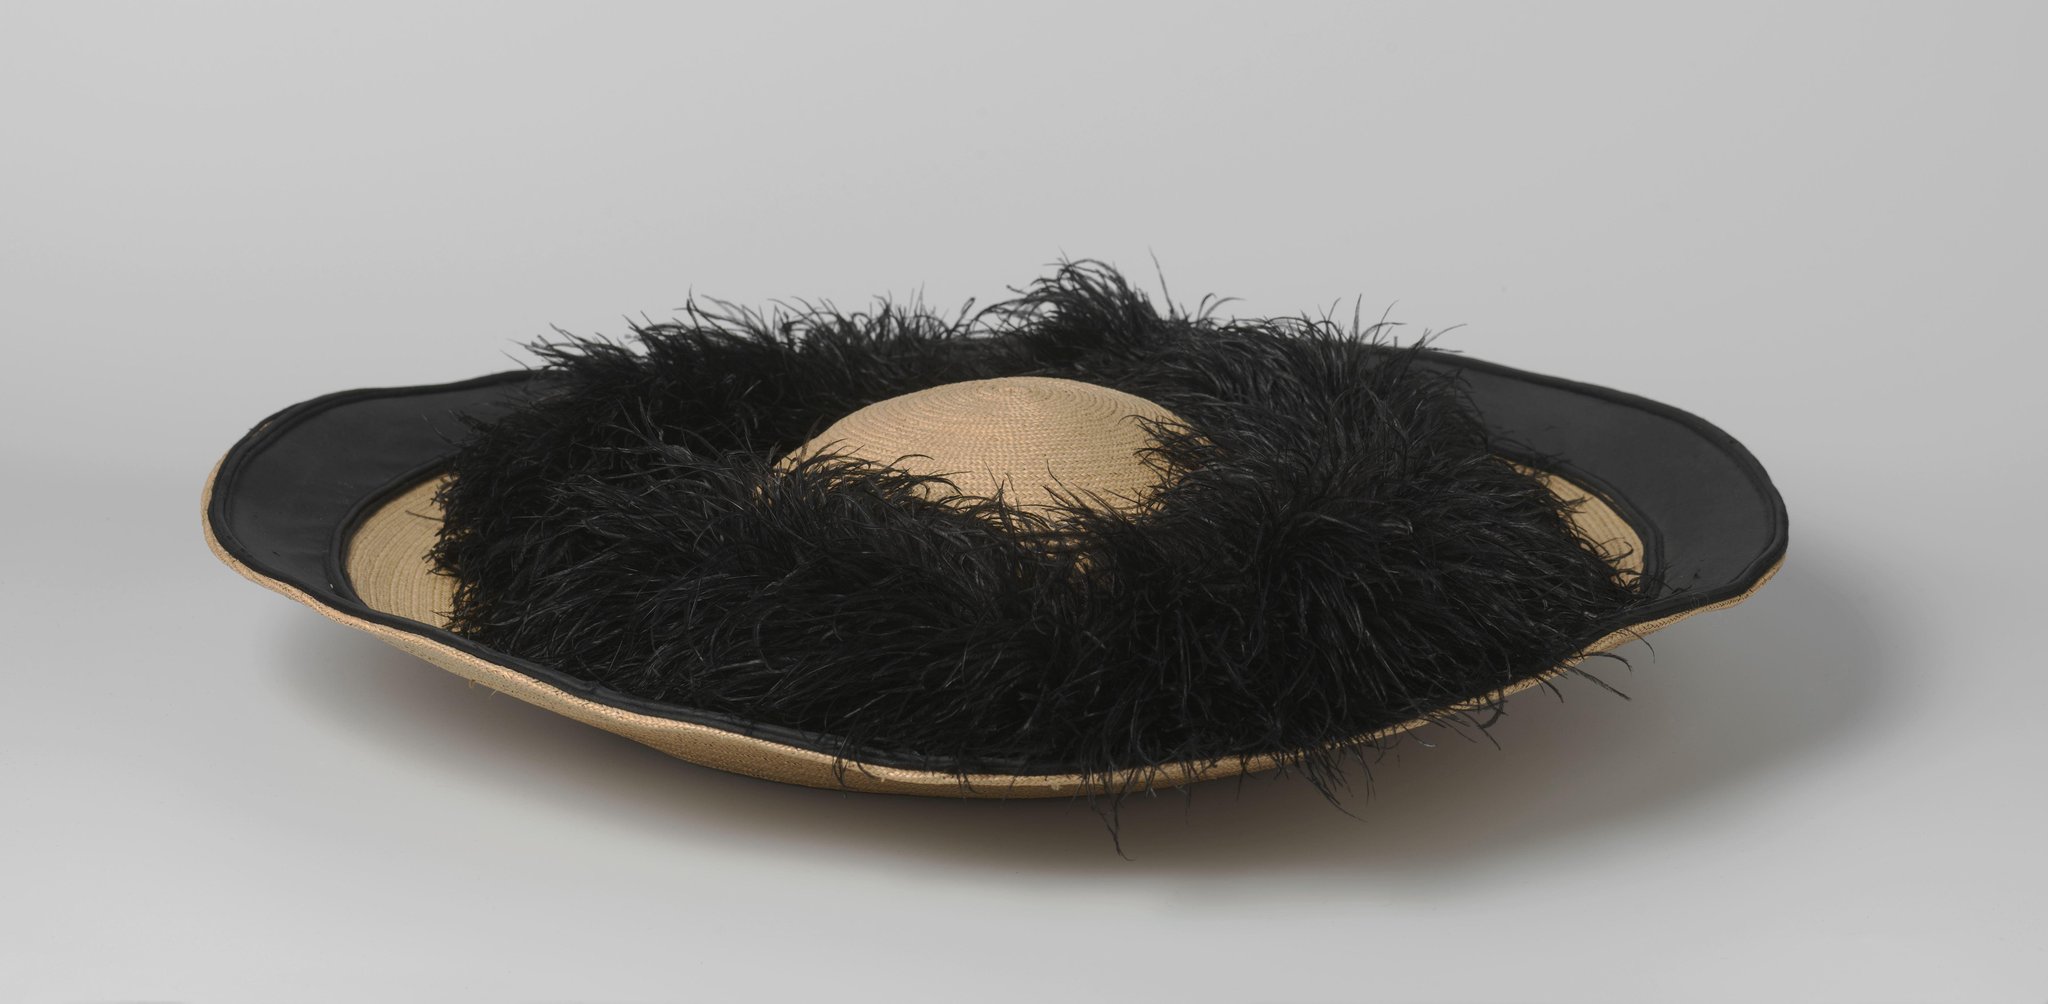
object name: womenswear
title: Hoed van stro, een rand van zwarte tafzijde en zwarte struisveren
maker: Anonymous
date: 1908-1915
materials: hair, textile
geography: the hague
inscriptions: label: ‘Spit & Cie // Den Haag’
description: Hoed van fijn, glad stro, zwarte tafzijde en zwarte struisveren. Model: Zeer platte bol, iets ovaal, van binnen opgevuld met haar. Zeer brede, platte rand, waarbovenop een tafzijde, met dikke biesjes afgezette rand aan de buitenzijde genaaid zit. Langs de aanzet van de bol een aaneengesloten wrong van zwarte struisveren, vanachter iets in een punt uitlopend.